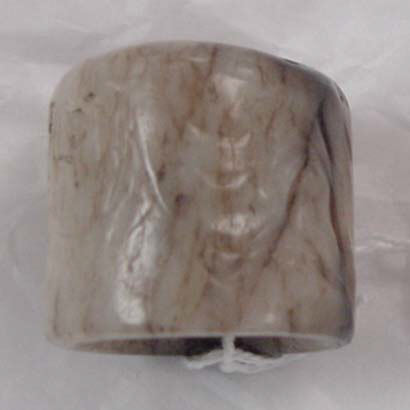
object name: ring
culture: chinese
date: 1801-1900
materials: jade